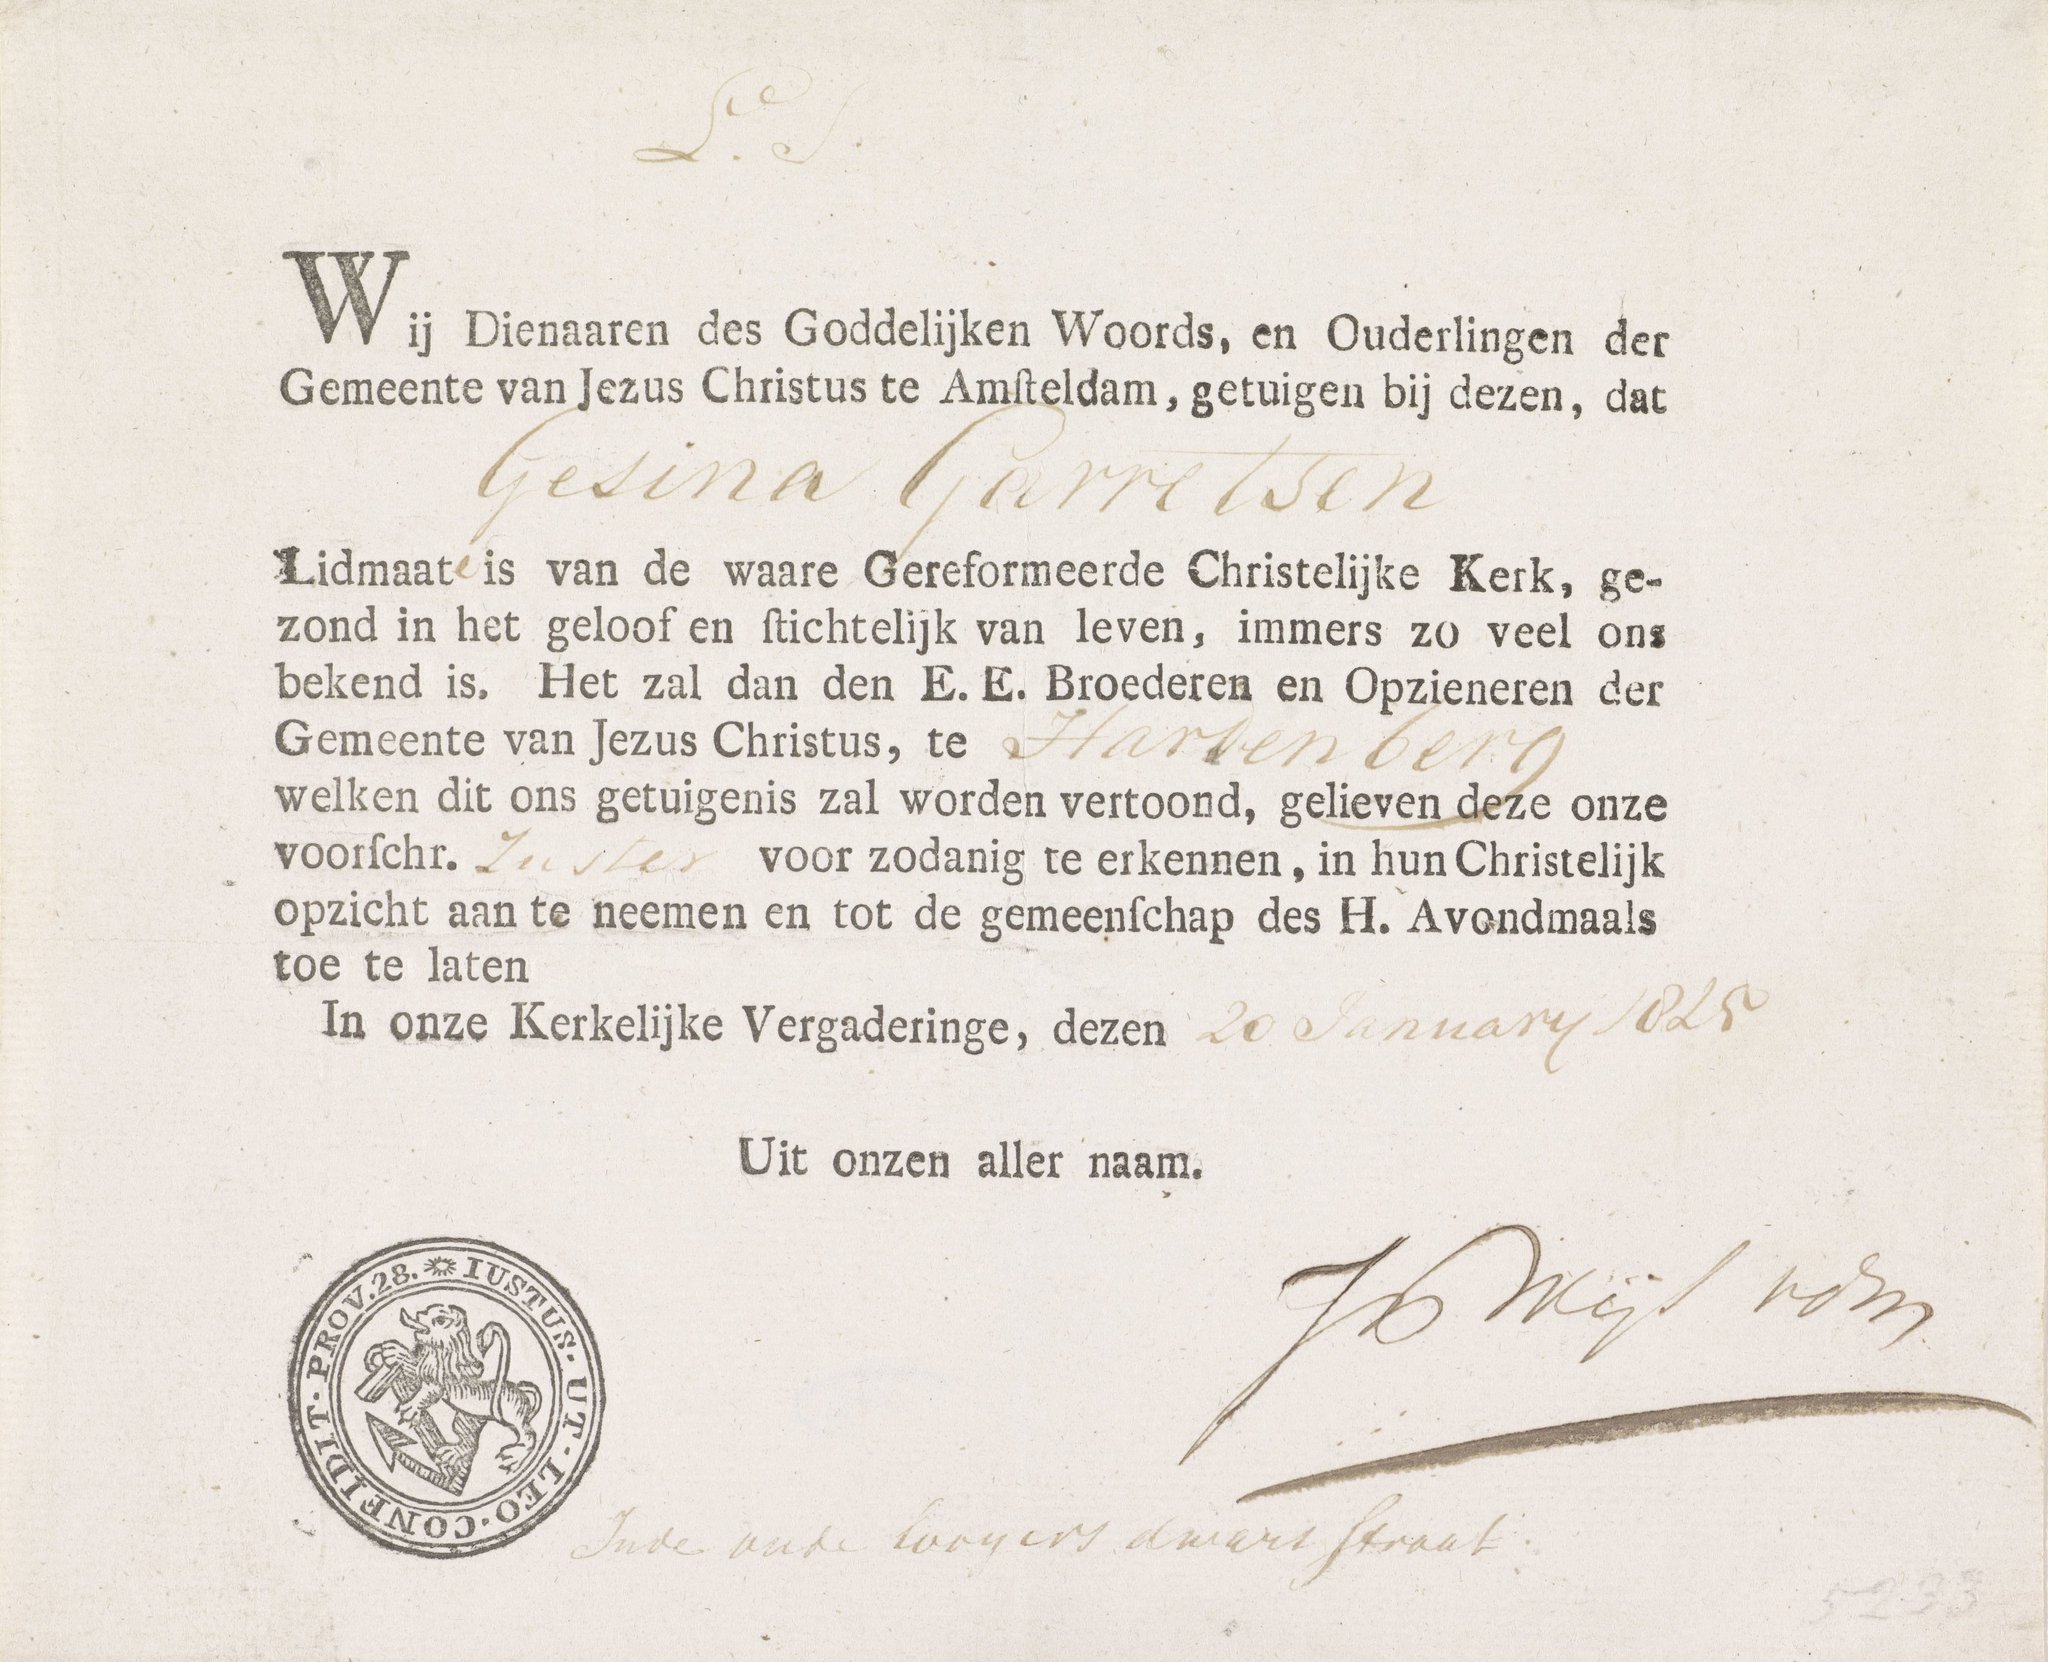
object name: text sheet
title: Attestatie van Gesina Garretsen bij de gereformeerde kerk te Amsterdam, 1825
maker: Anonymous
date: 1820-1825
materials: paper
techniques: letterpress printing, pen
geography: amsterdam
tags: amsterdam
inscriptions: collector's mark: Lugt 2228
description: Kerkelijk getuigschrift van Gesina Garretsen als goed lidmaat van de gereformeerde kerk te Amsterdam, 20 januari 1825, bij haar vertrek naar Hardenberg. Voorgedrukte tekstblad waarin de namen en data zmet de hand zijn ingevuld. Linksonder een vignet.